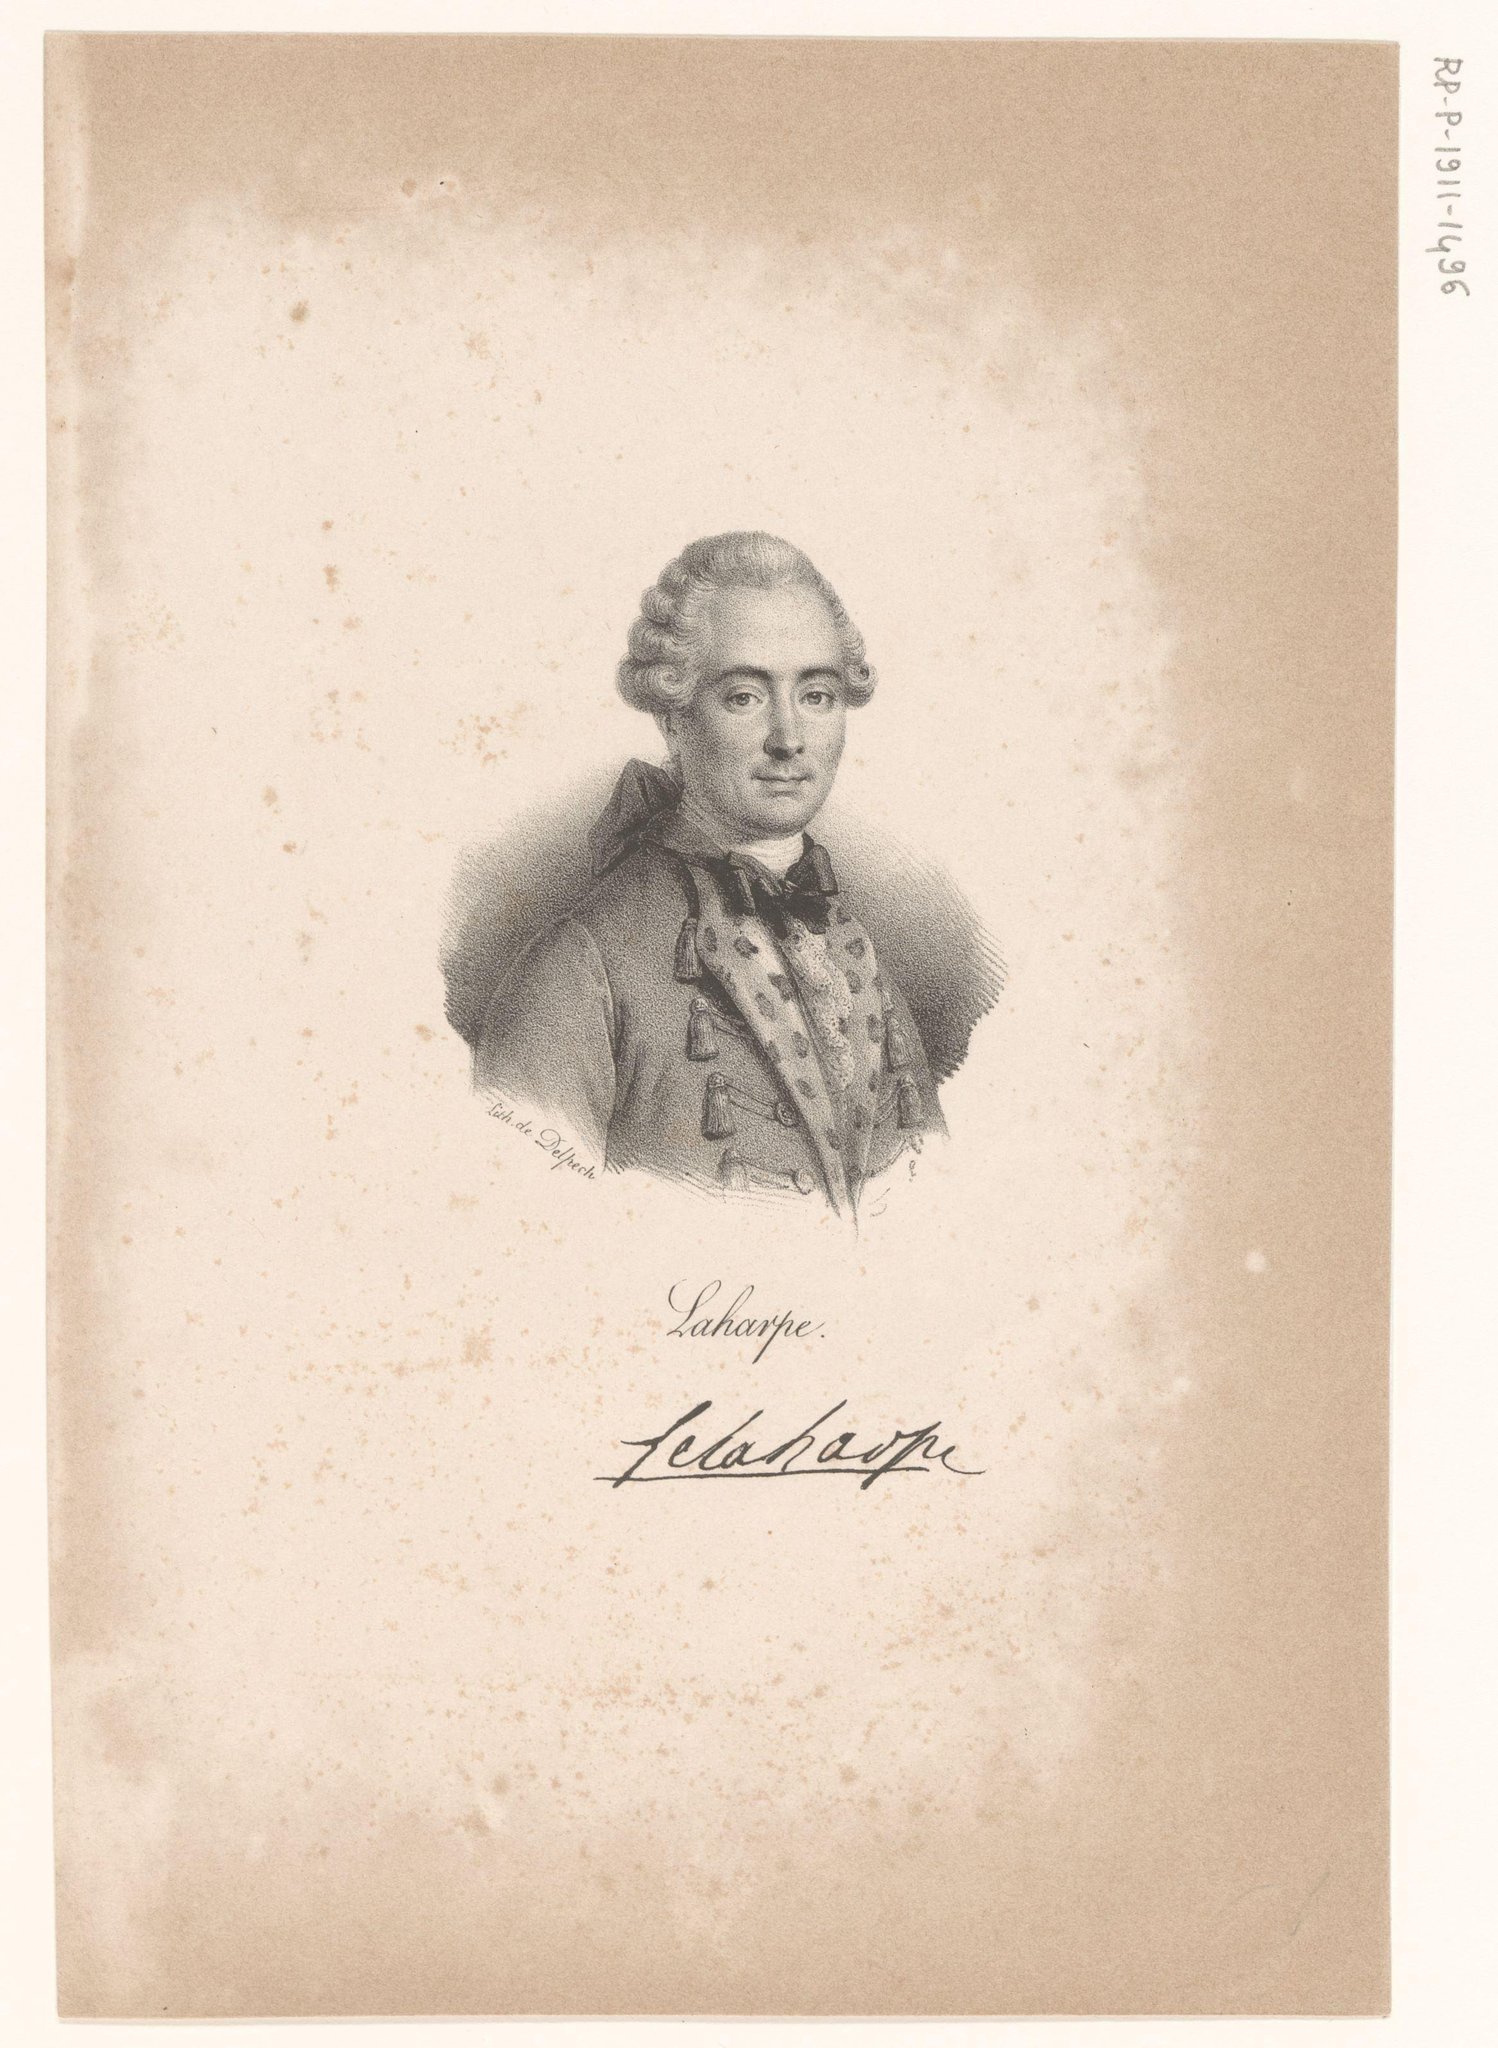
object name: print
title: Laharpe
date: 1818-1842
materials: paper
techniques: lithograph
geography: paris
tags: paris, historical persons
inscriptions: collector's mark: Lugt 2228a